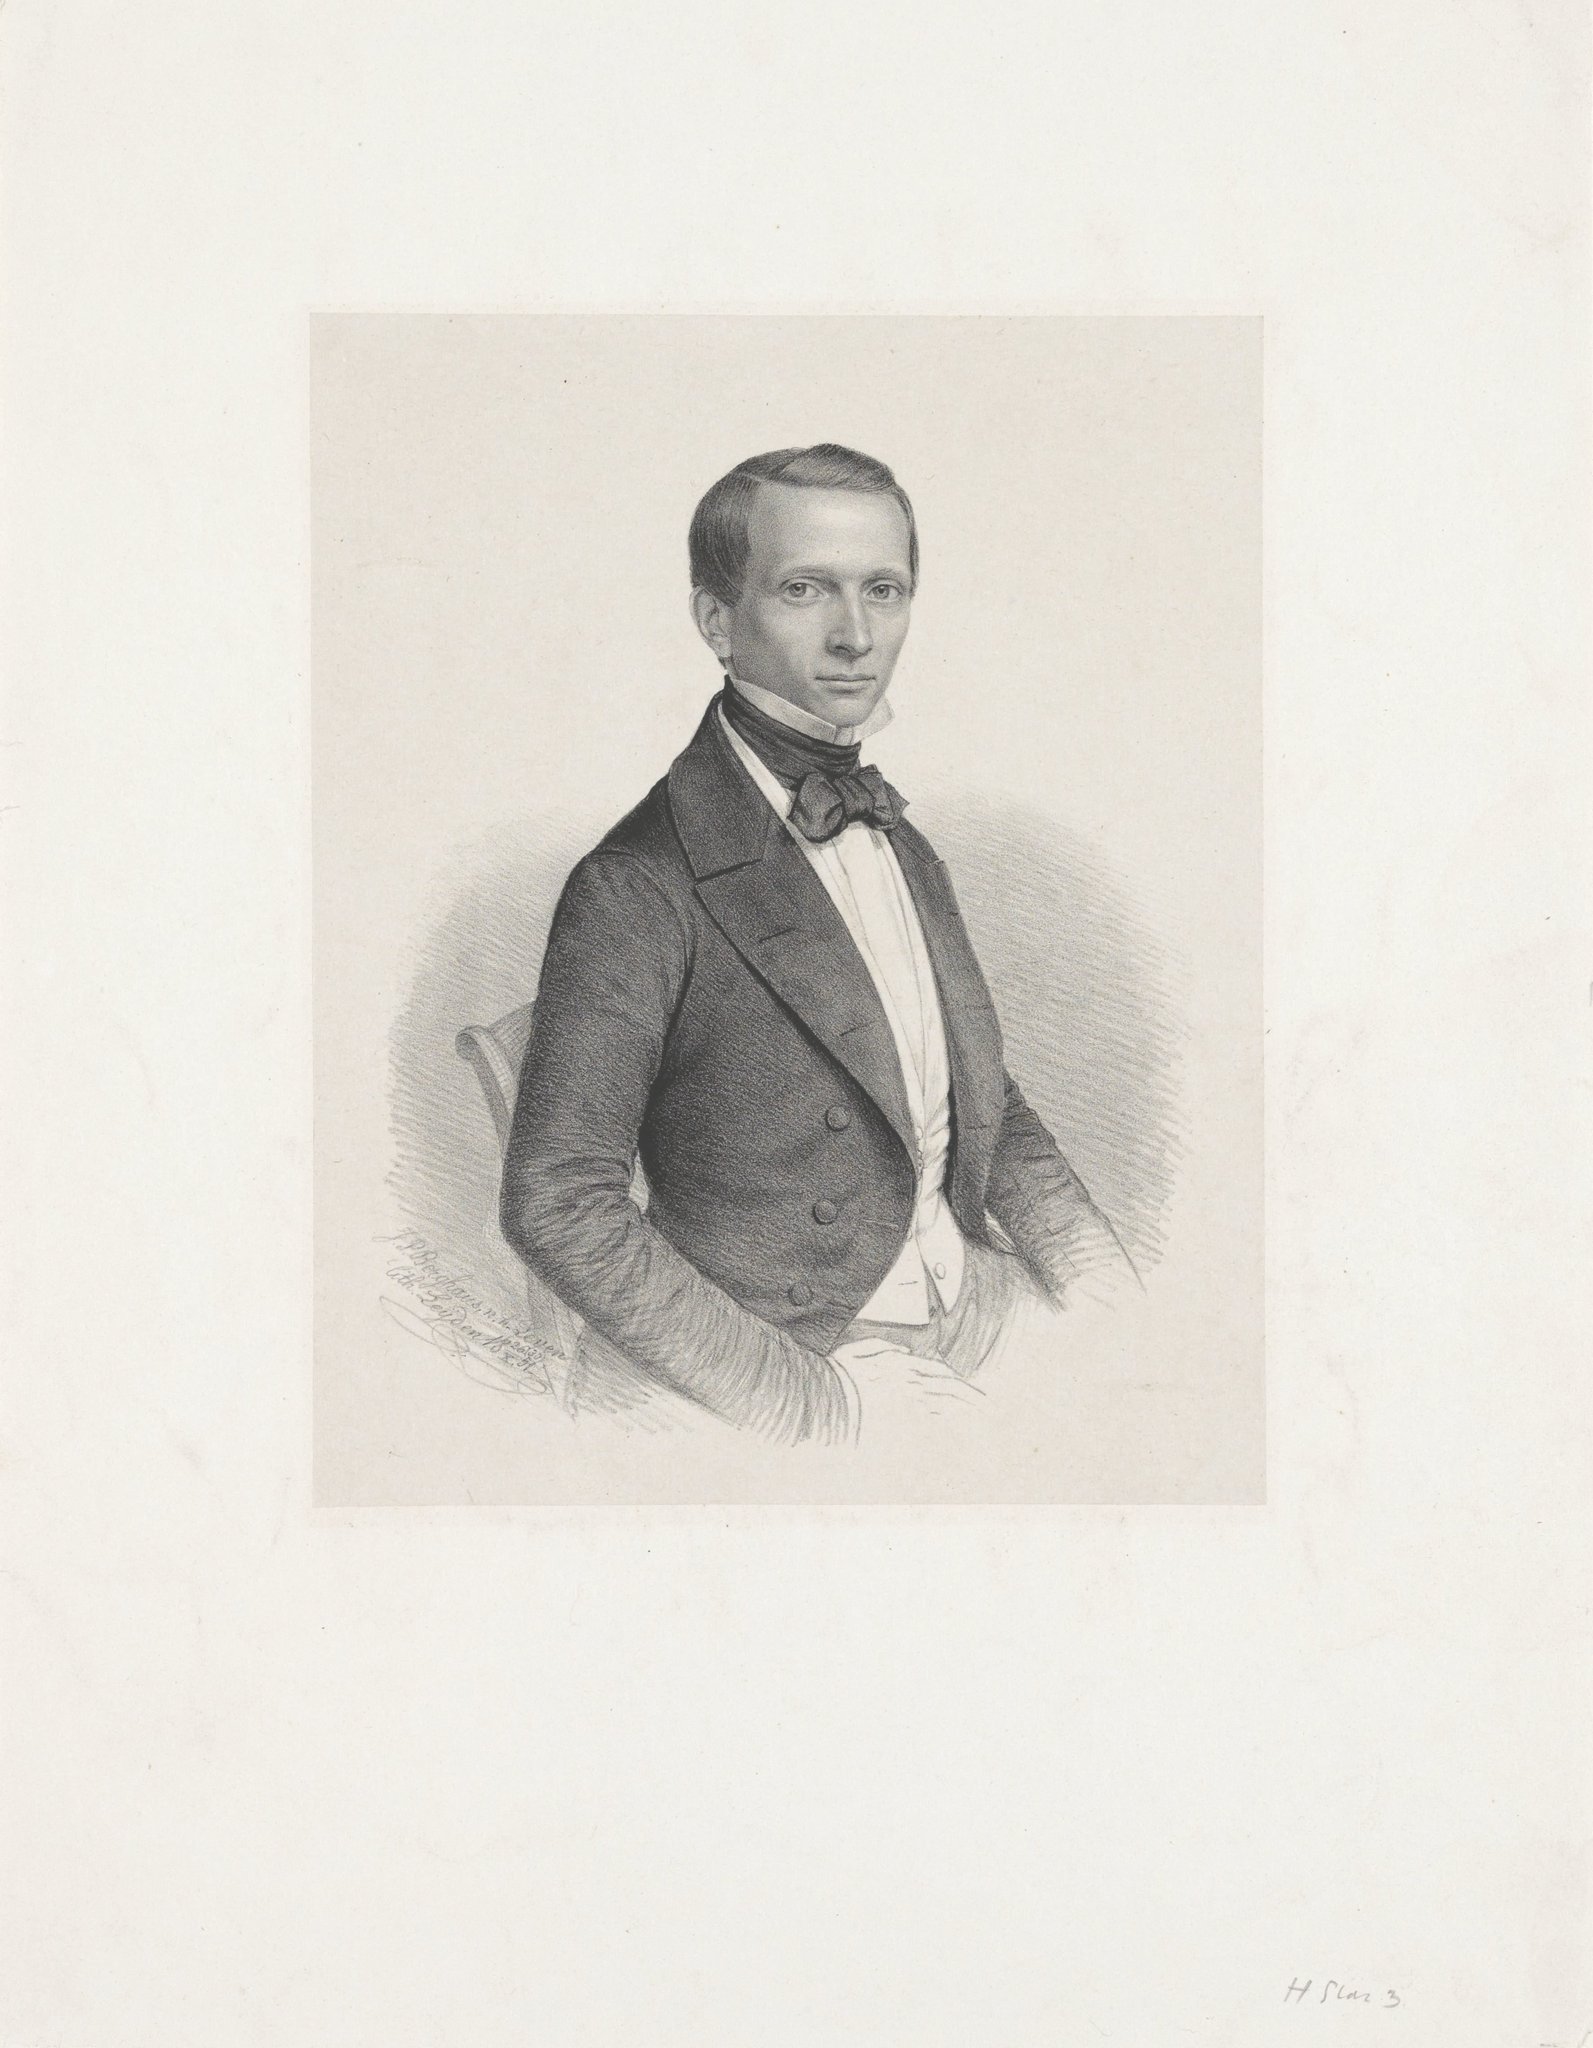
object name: print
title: Portret van een onbekende man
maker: johann peter berghaus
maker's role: print maker, printer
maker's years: 1810-1870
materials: paper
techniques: lithograph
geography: leiden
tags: historical persons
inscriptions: collector's mark: Lugt 2228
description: De geportretteerde zit op een stoel en heeft zijn bovenlichaam naar rechts gedraaid. Zijn handen rusten op zijn bovenbenen.